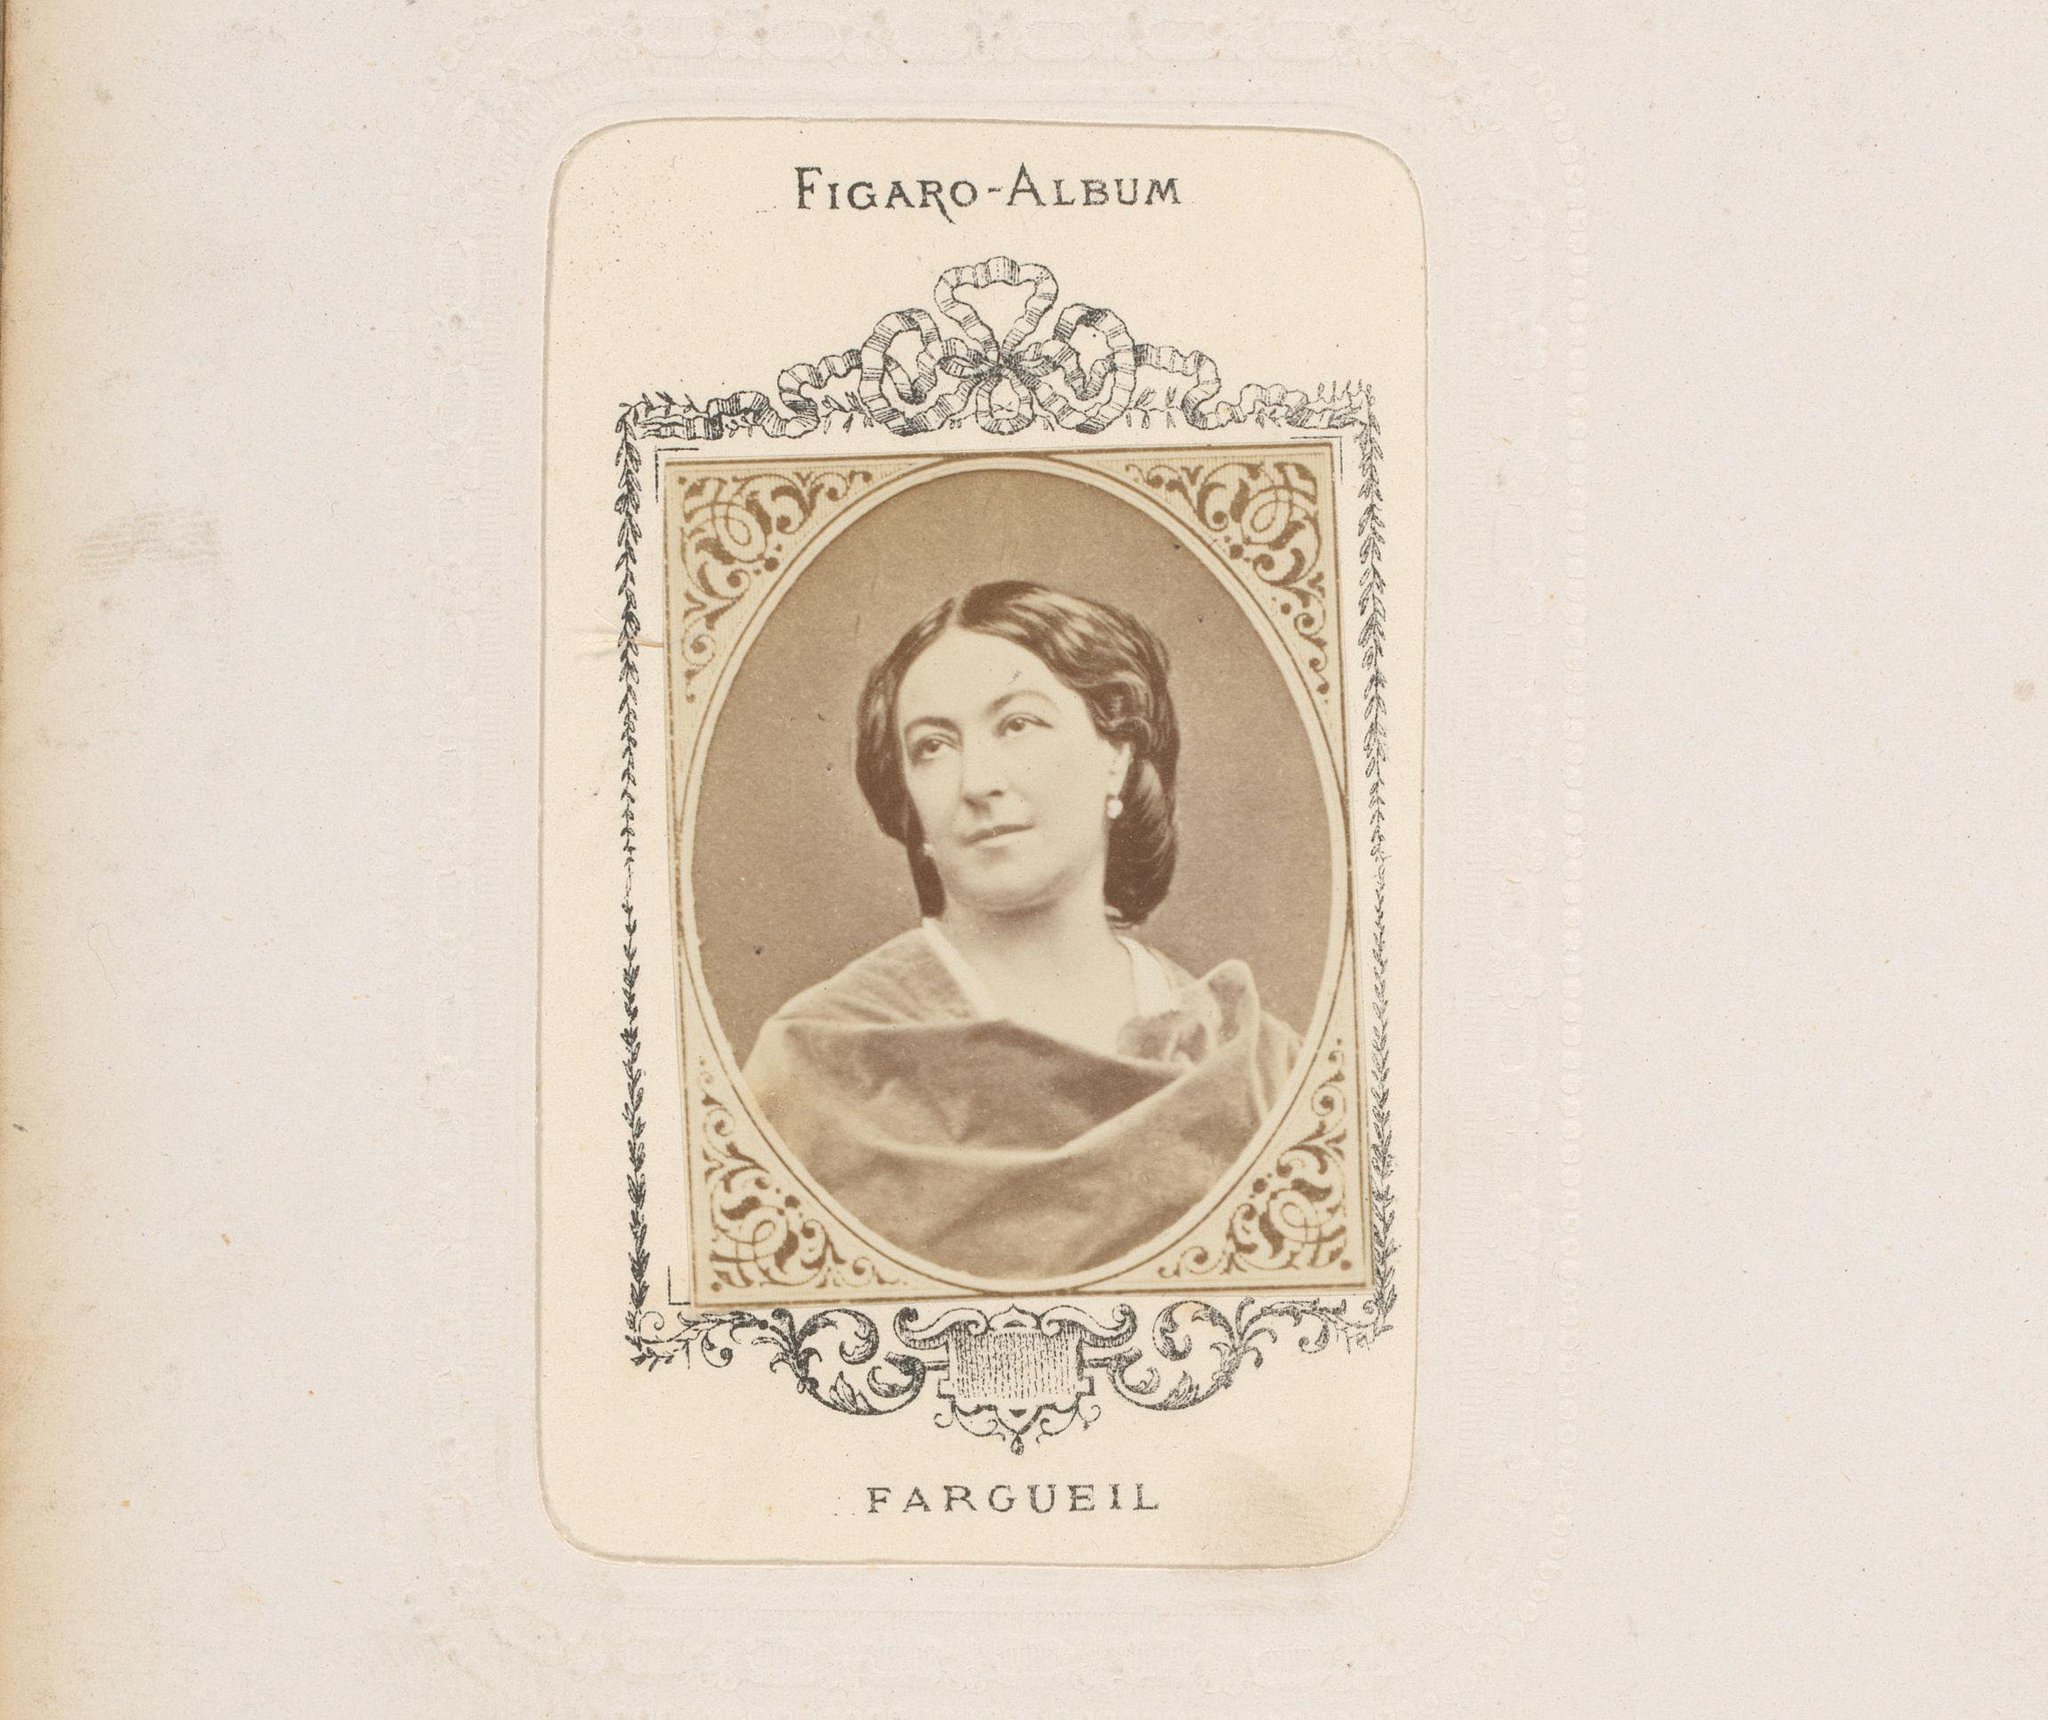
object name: album leaf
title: Fotoreproductie van een portret van Anaïs Fargueil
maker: Anonymous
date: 1860-1900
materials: cardboard, photographic support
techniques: albumen print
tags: historical persons - bb - woman, portrait of actor, actress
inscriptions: inscription: ‘Figaro-Album/ Fargueil/ Liébert Phot.’